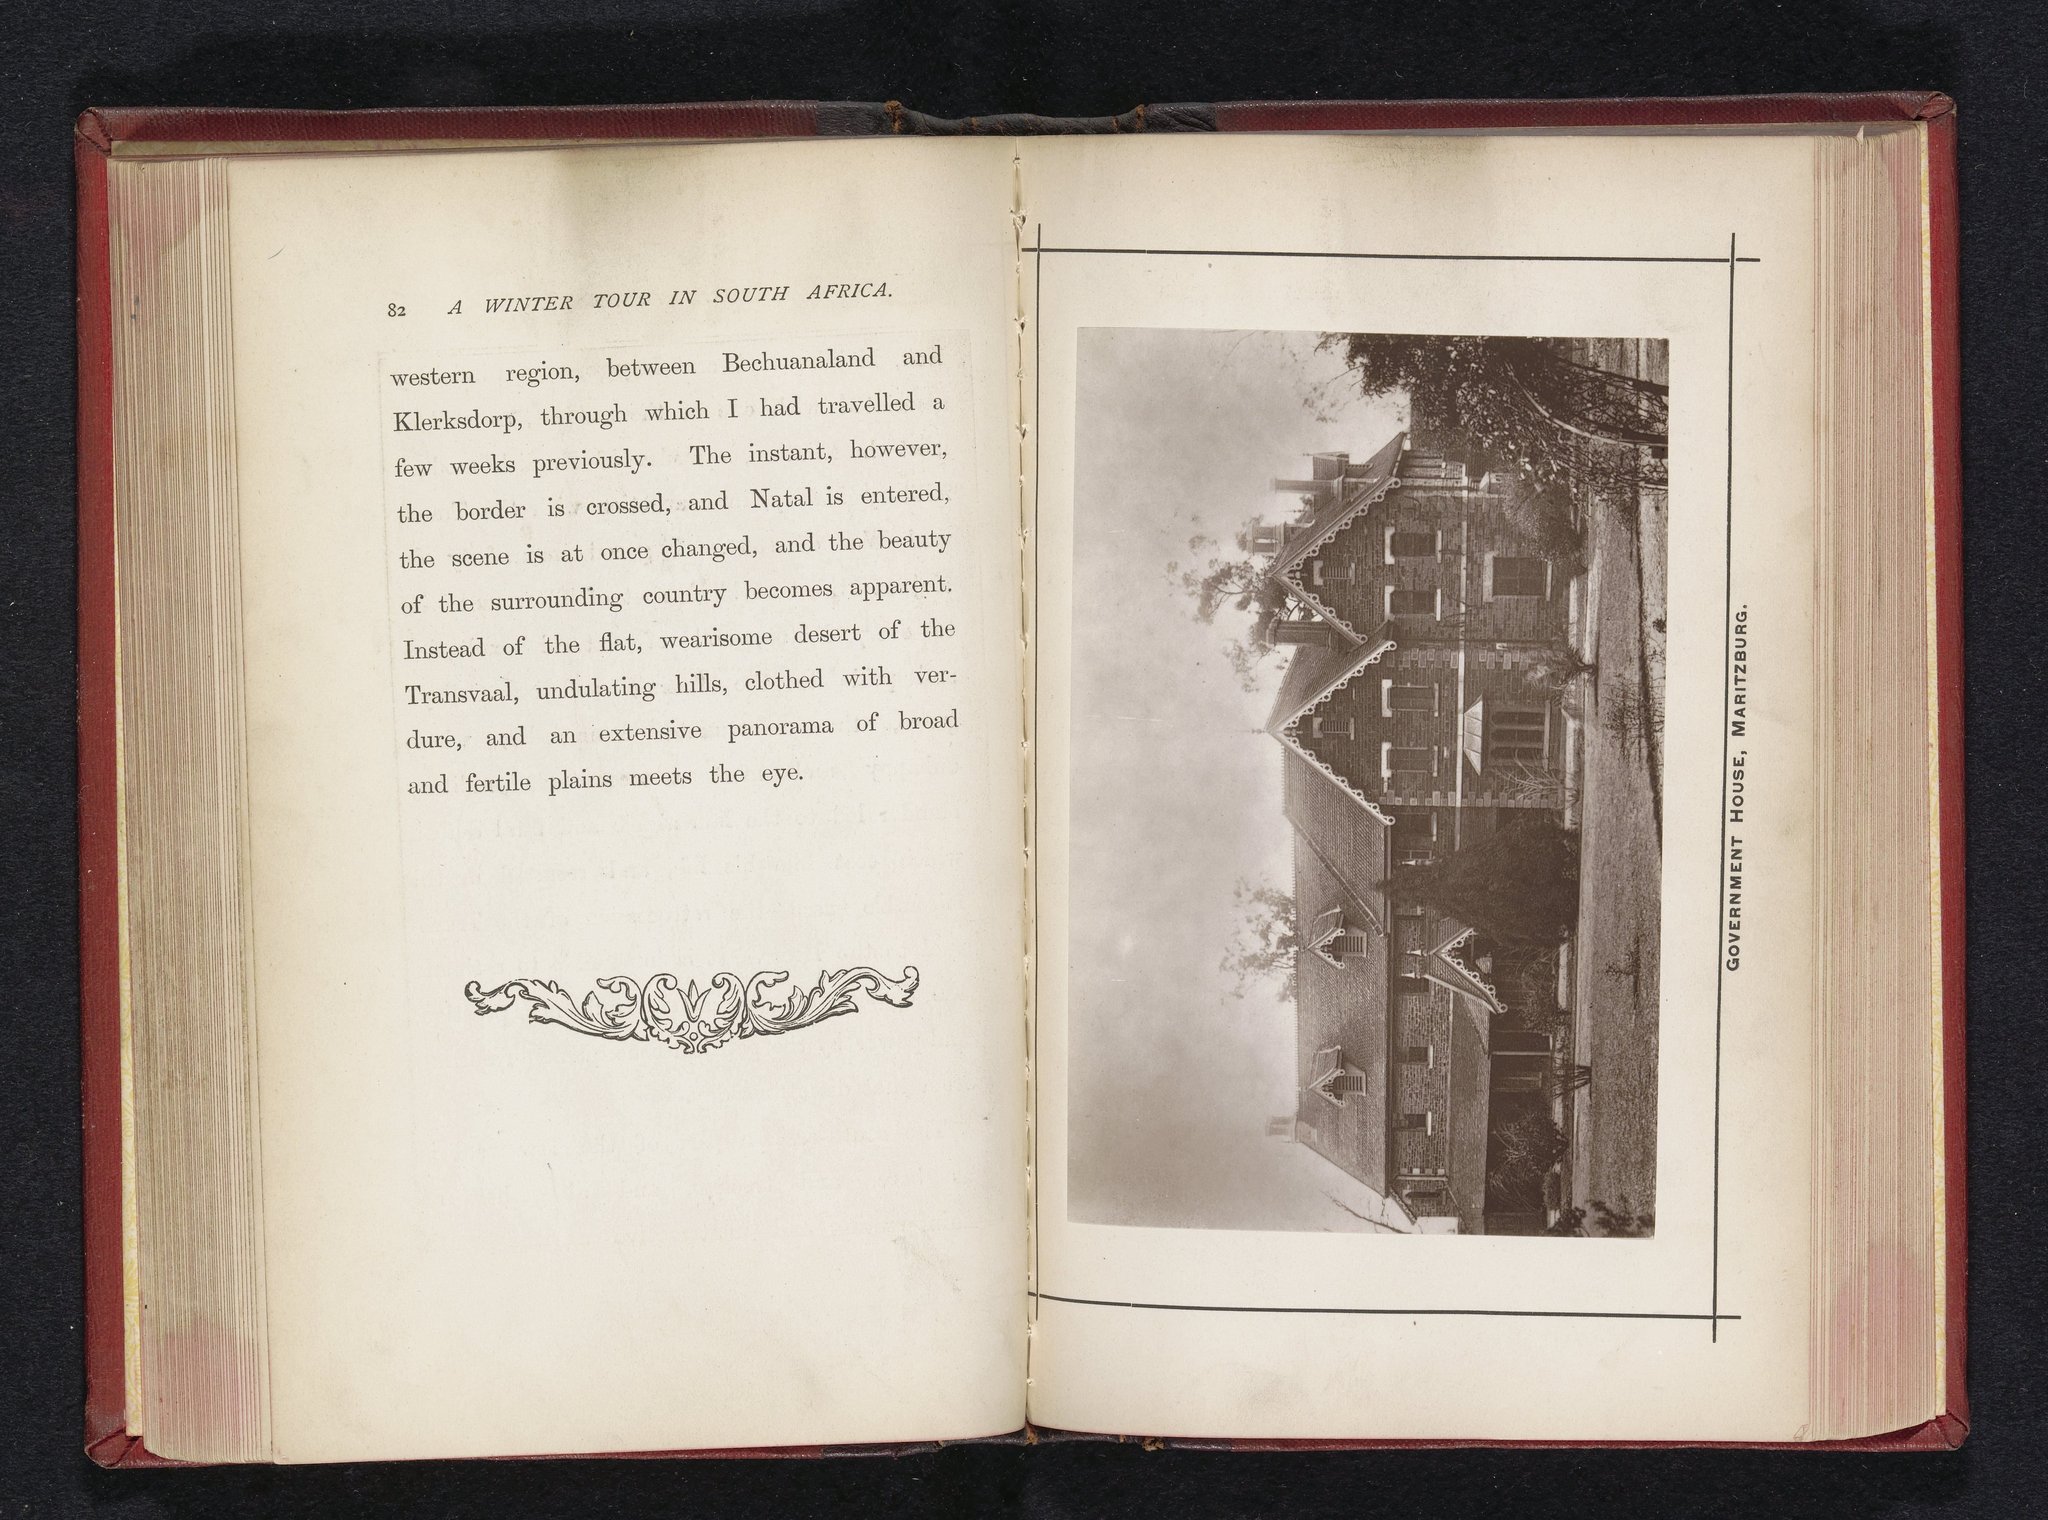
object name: photomechanical print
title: Gezicht op een overheidsgebouw in Pietermaritzburg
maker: Anonymous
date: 1888-1890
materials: paper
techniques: woodburytype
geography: pietermaritzburg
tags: façade (of house or building), colonial government